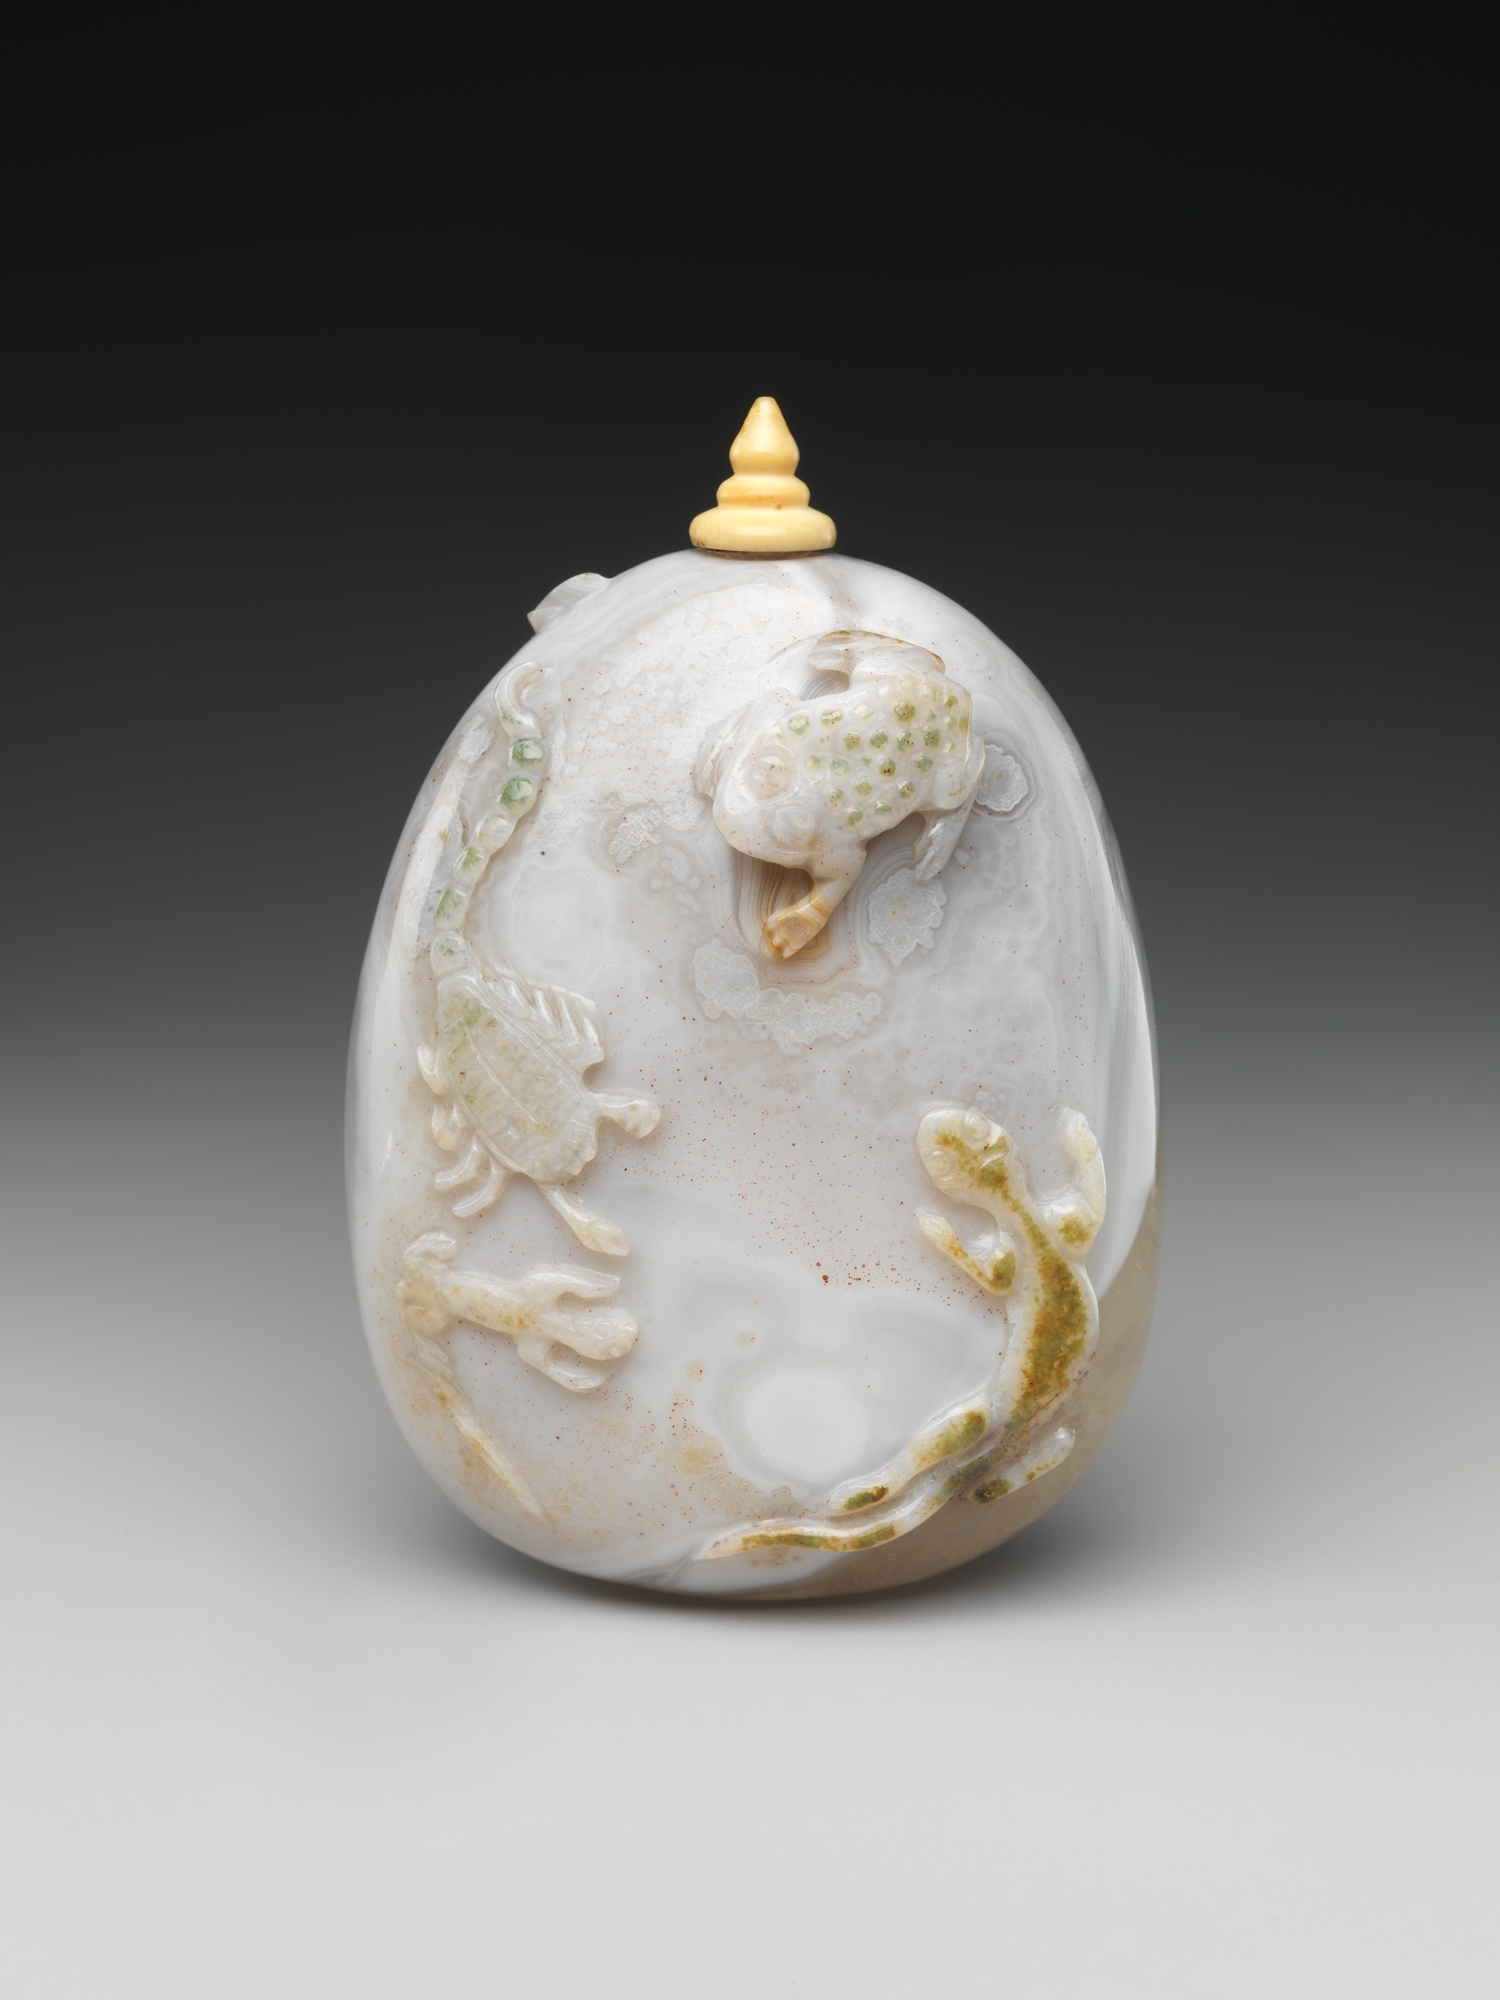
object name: snuff bottle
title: Snuff Bottle with Poisonous Animals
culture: chinese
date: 1801-1900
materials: stone, ivory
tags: frogs,butterflies,scorpions,lizards